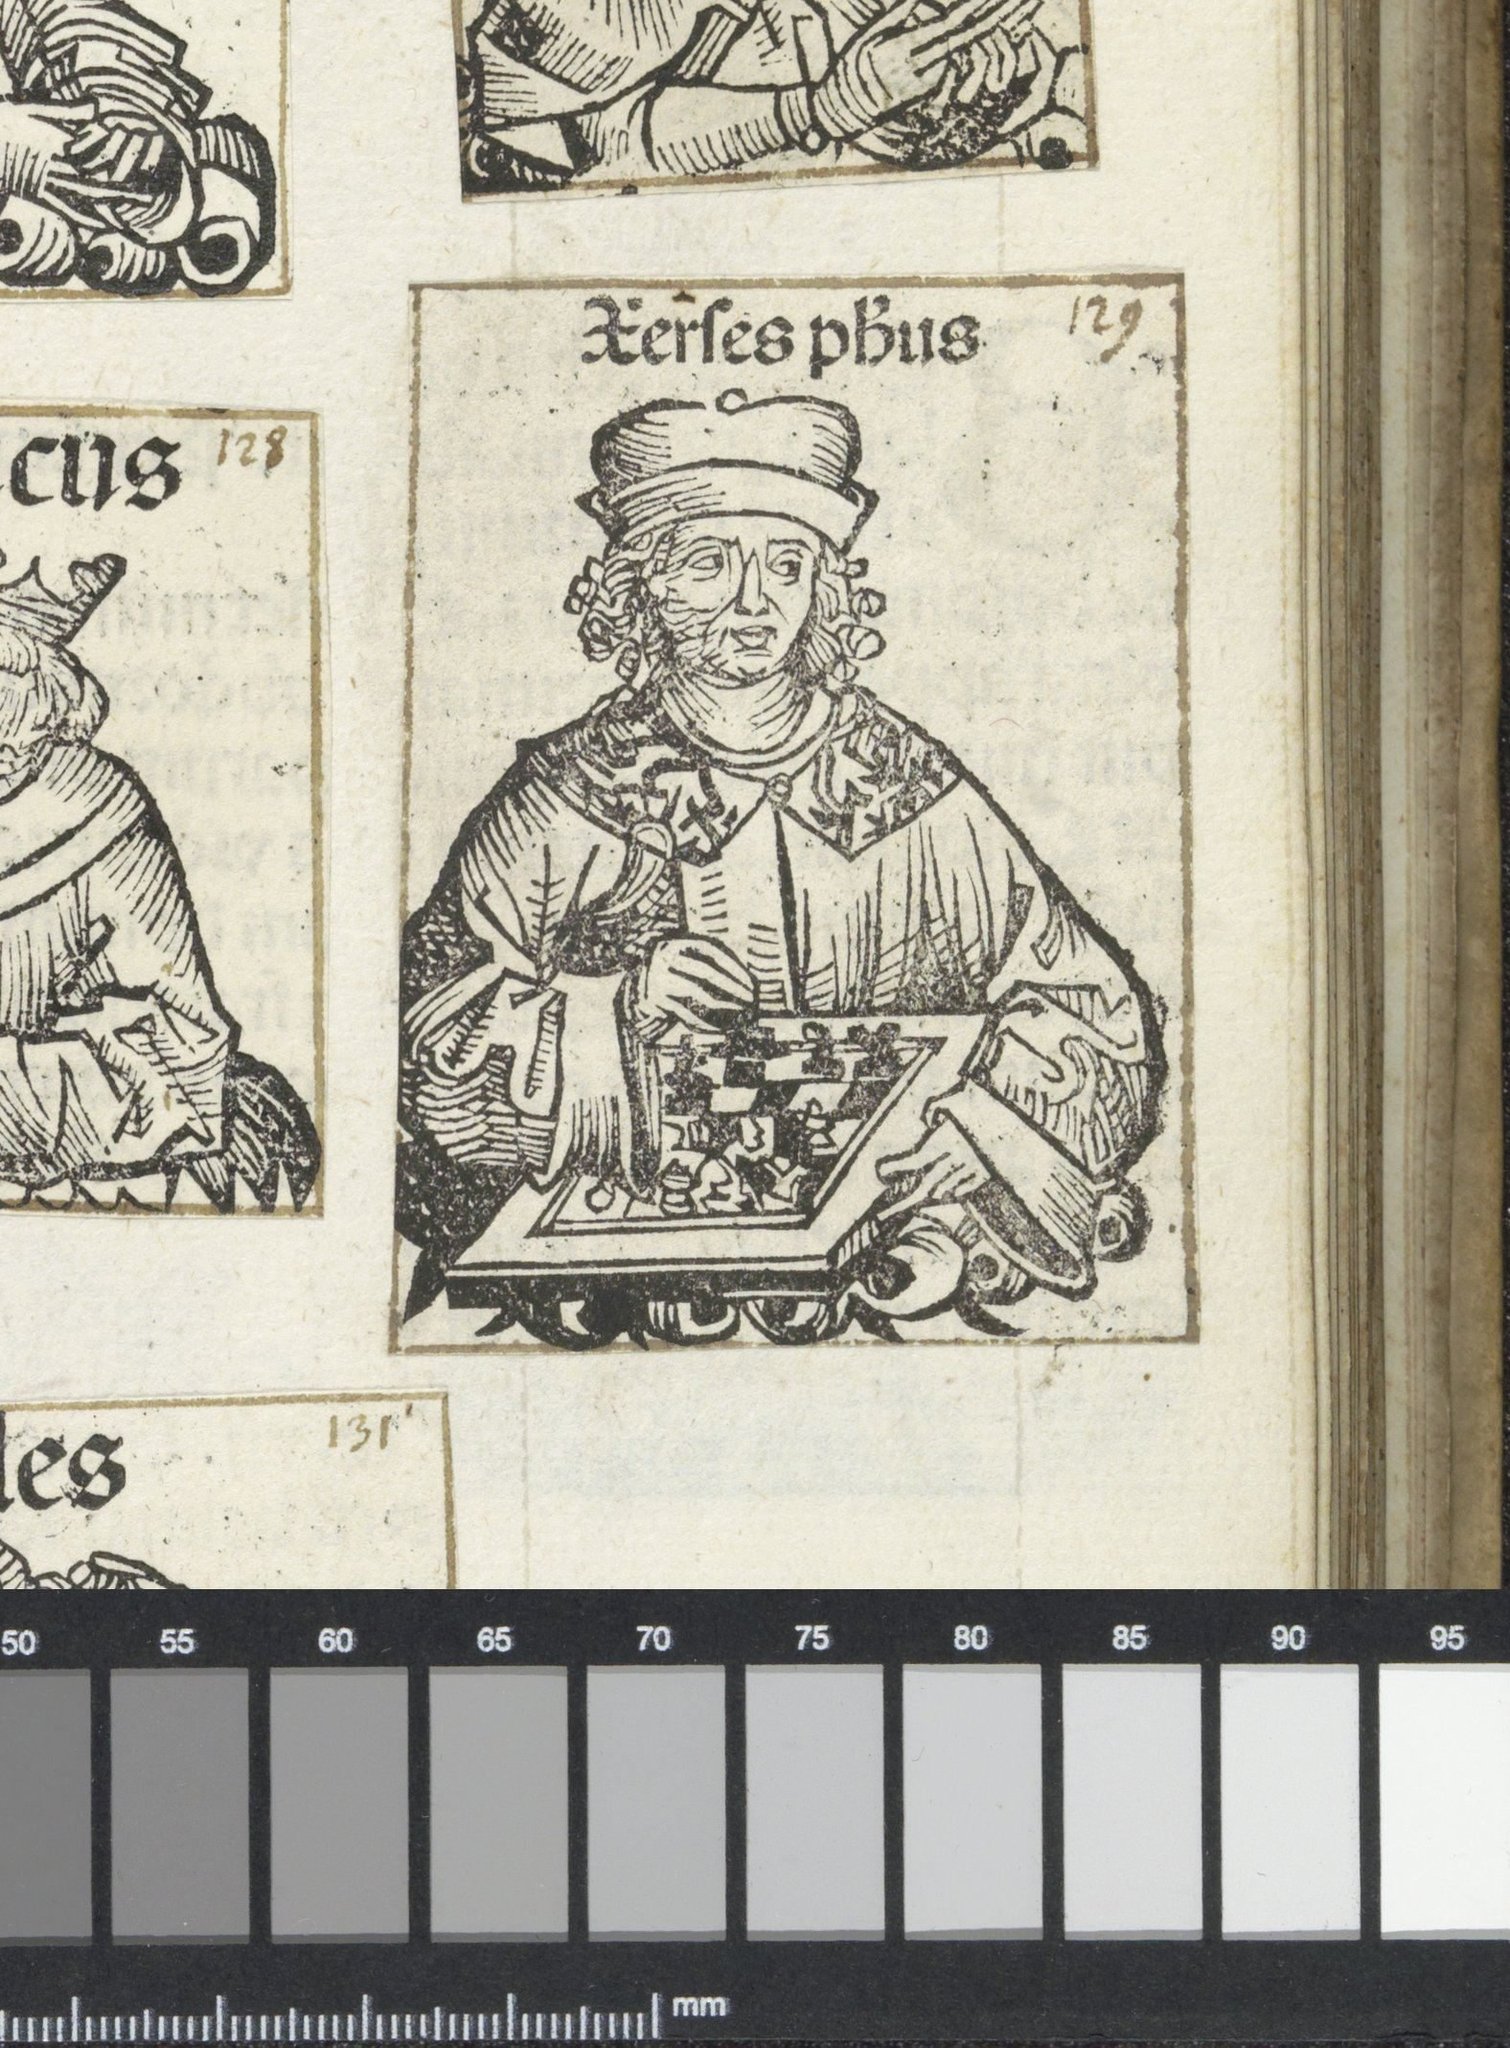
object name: print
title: Xerxes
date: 1493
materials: paper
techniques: letterpress printing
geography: nuremberg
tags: chess, persons from the old testament (not in biblical context, nor occurring in legendary/historical extensions included in division 71)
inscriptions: inscription: ‘129’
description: De houtsnede wordt gebruikt als boekillustratie in de Liber Chronicarum (of Neurenbergkroniek) van Hartmann Schedel, verschenen in het Latijn en Duits in 1493. Zie de Latijnse uitgave, folio 62v.